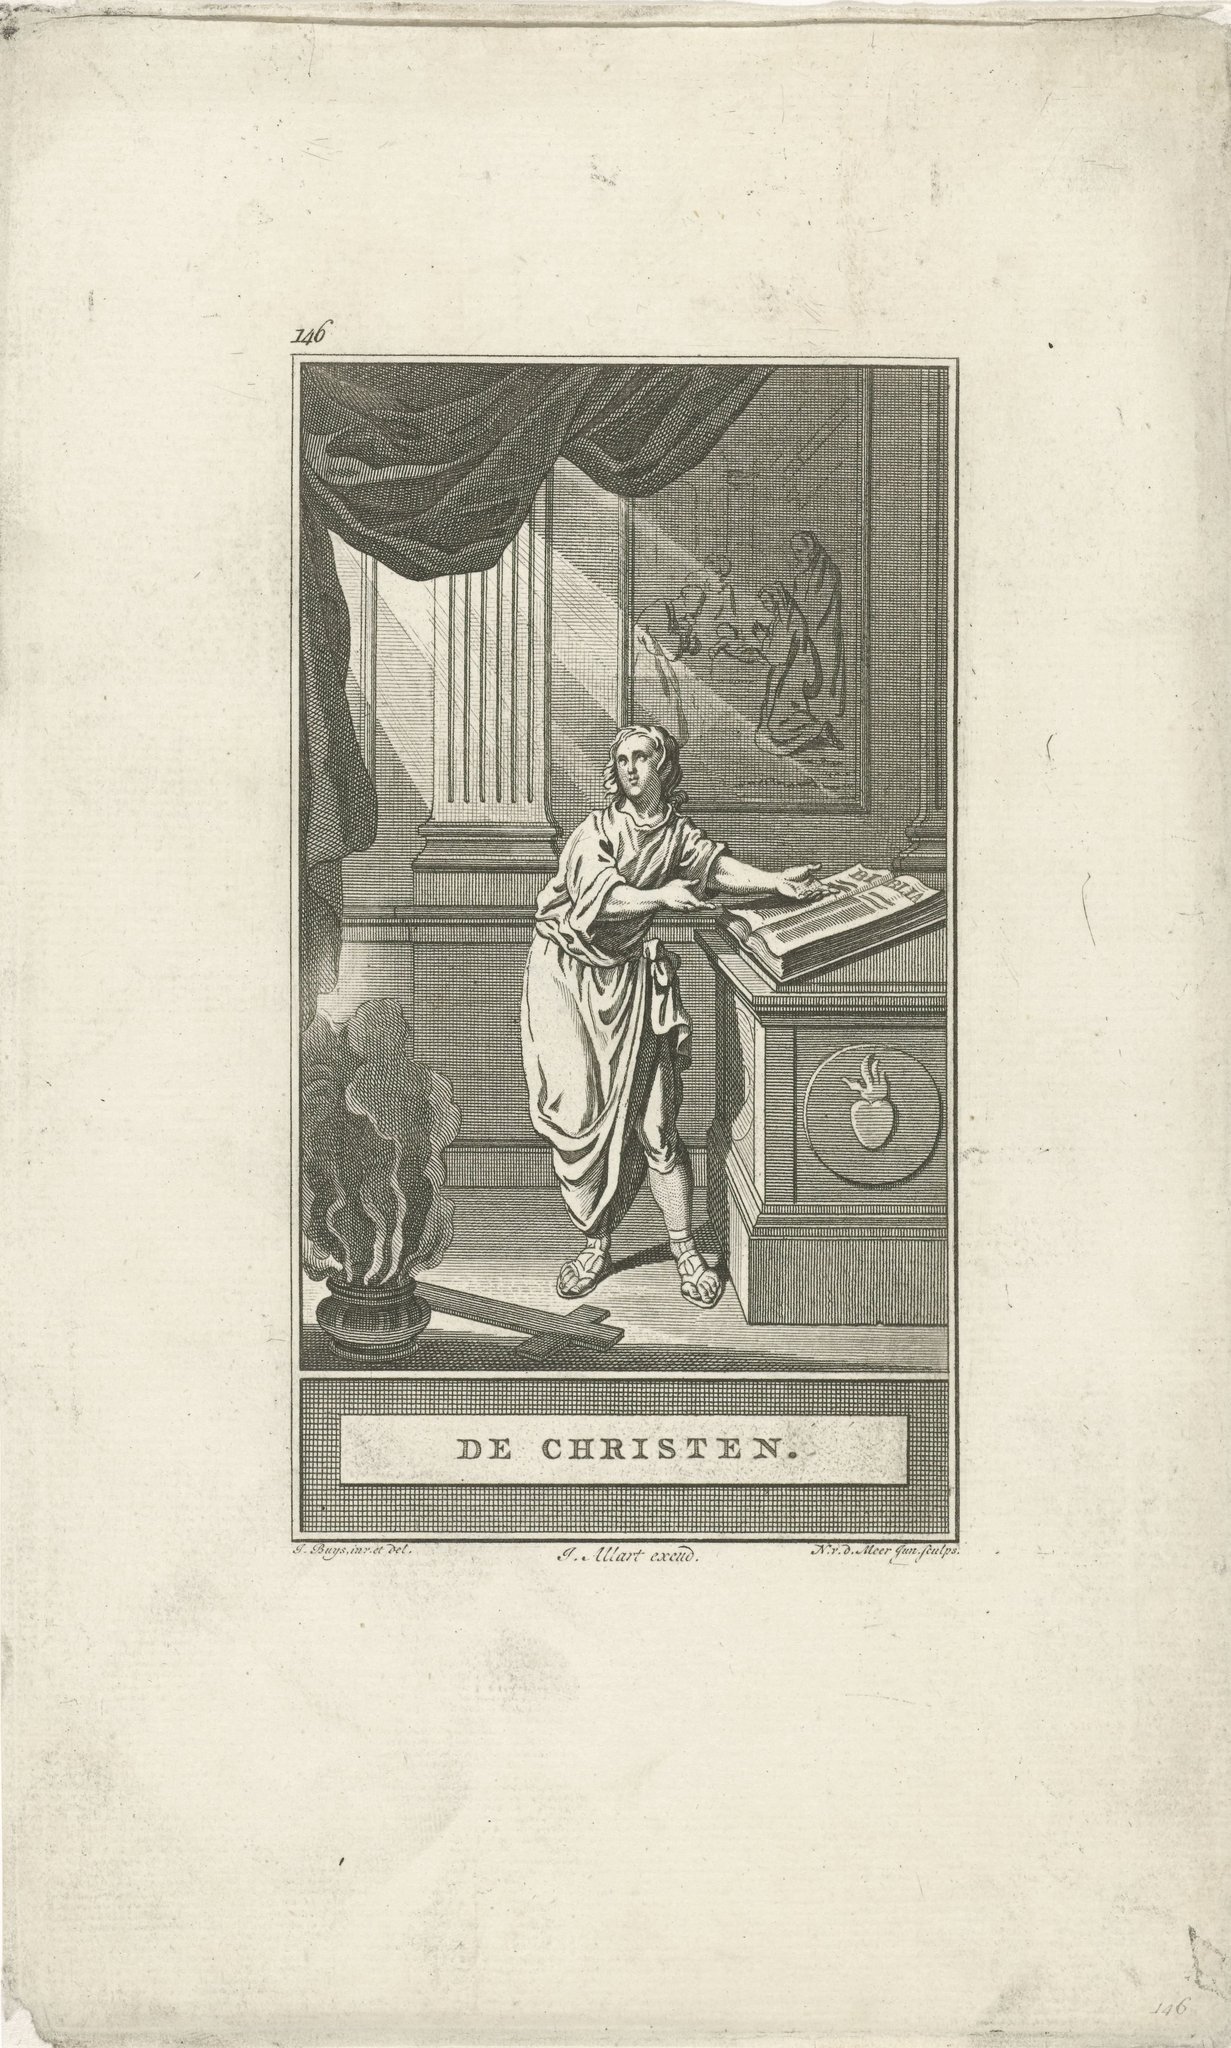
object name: book illustration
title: De christen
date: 1778-1785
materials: paper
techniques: etching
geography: amsterdam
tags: adoration of the christ-child by the shepherds; mary and joseph present, the cross ~ symbols of christ, the believer, the bible as a book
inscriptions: collector's mark: Lugt 2228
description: Prent bij: Gellert, Christian Fürchtegott. Fabelen en vertelsels. 3 dln. Amsterdam: Pieter Meyer, 1772-1774. De prenten bij deze publicatie werden later uitgegeven. De exemplaren uitgegeven door de weduwe Jacobus Loveringh & Johannes Allart tussen 1777 en 1778, de exemplaren uitgegeven door alleen Johannes Allart tussen 1778 en 1785.